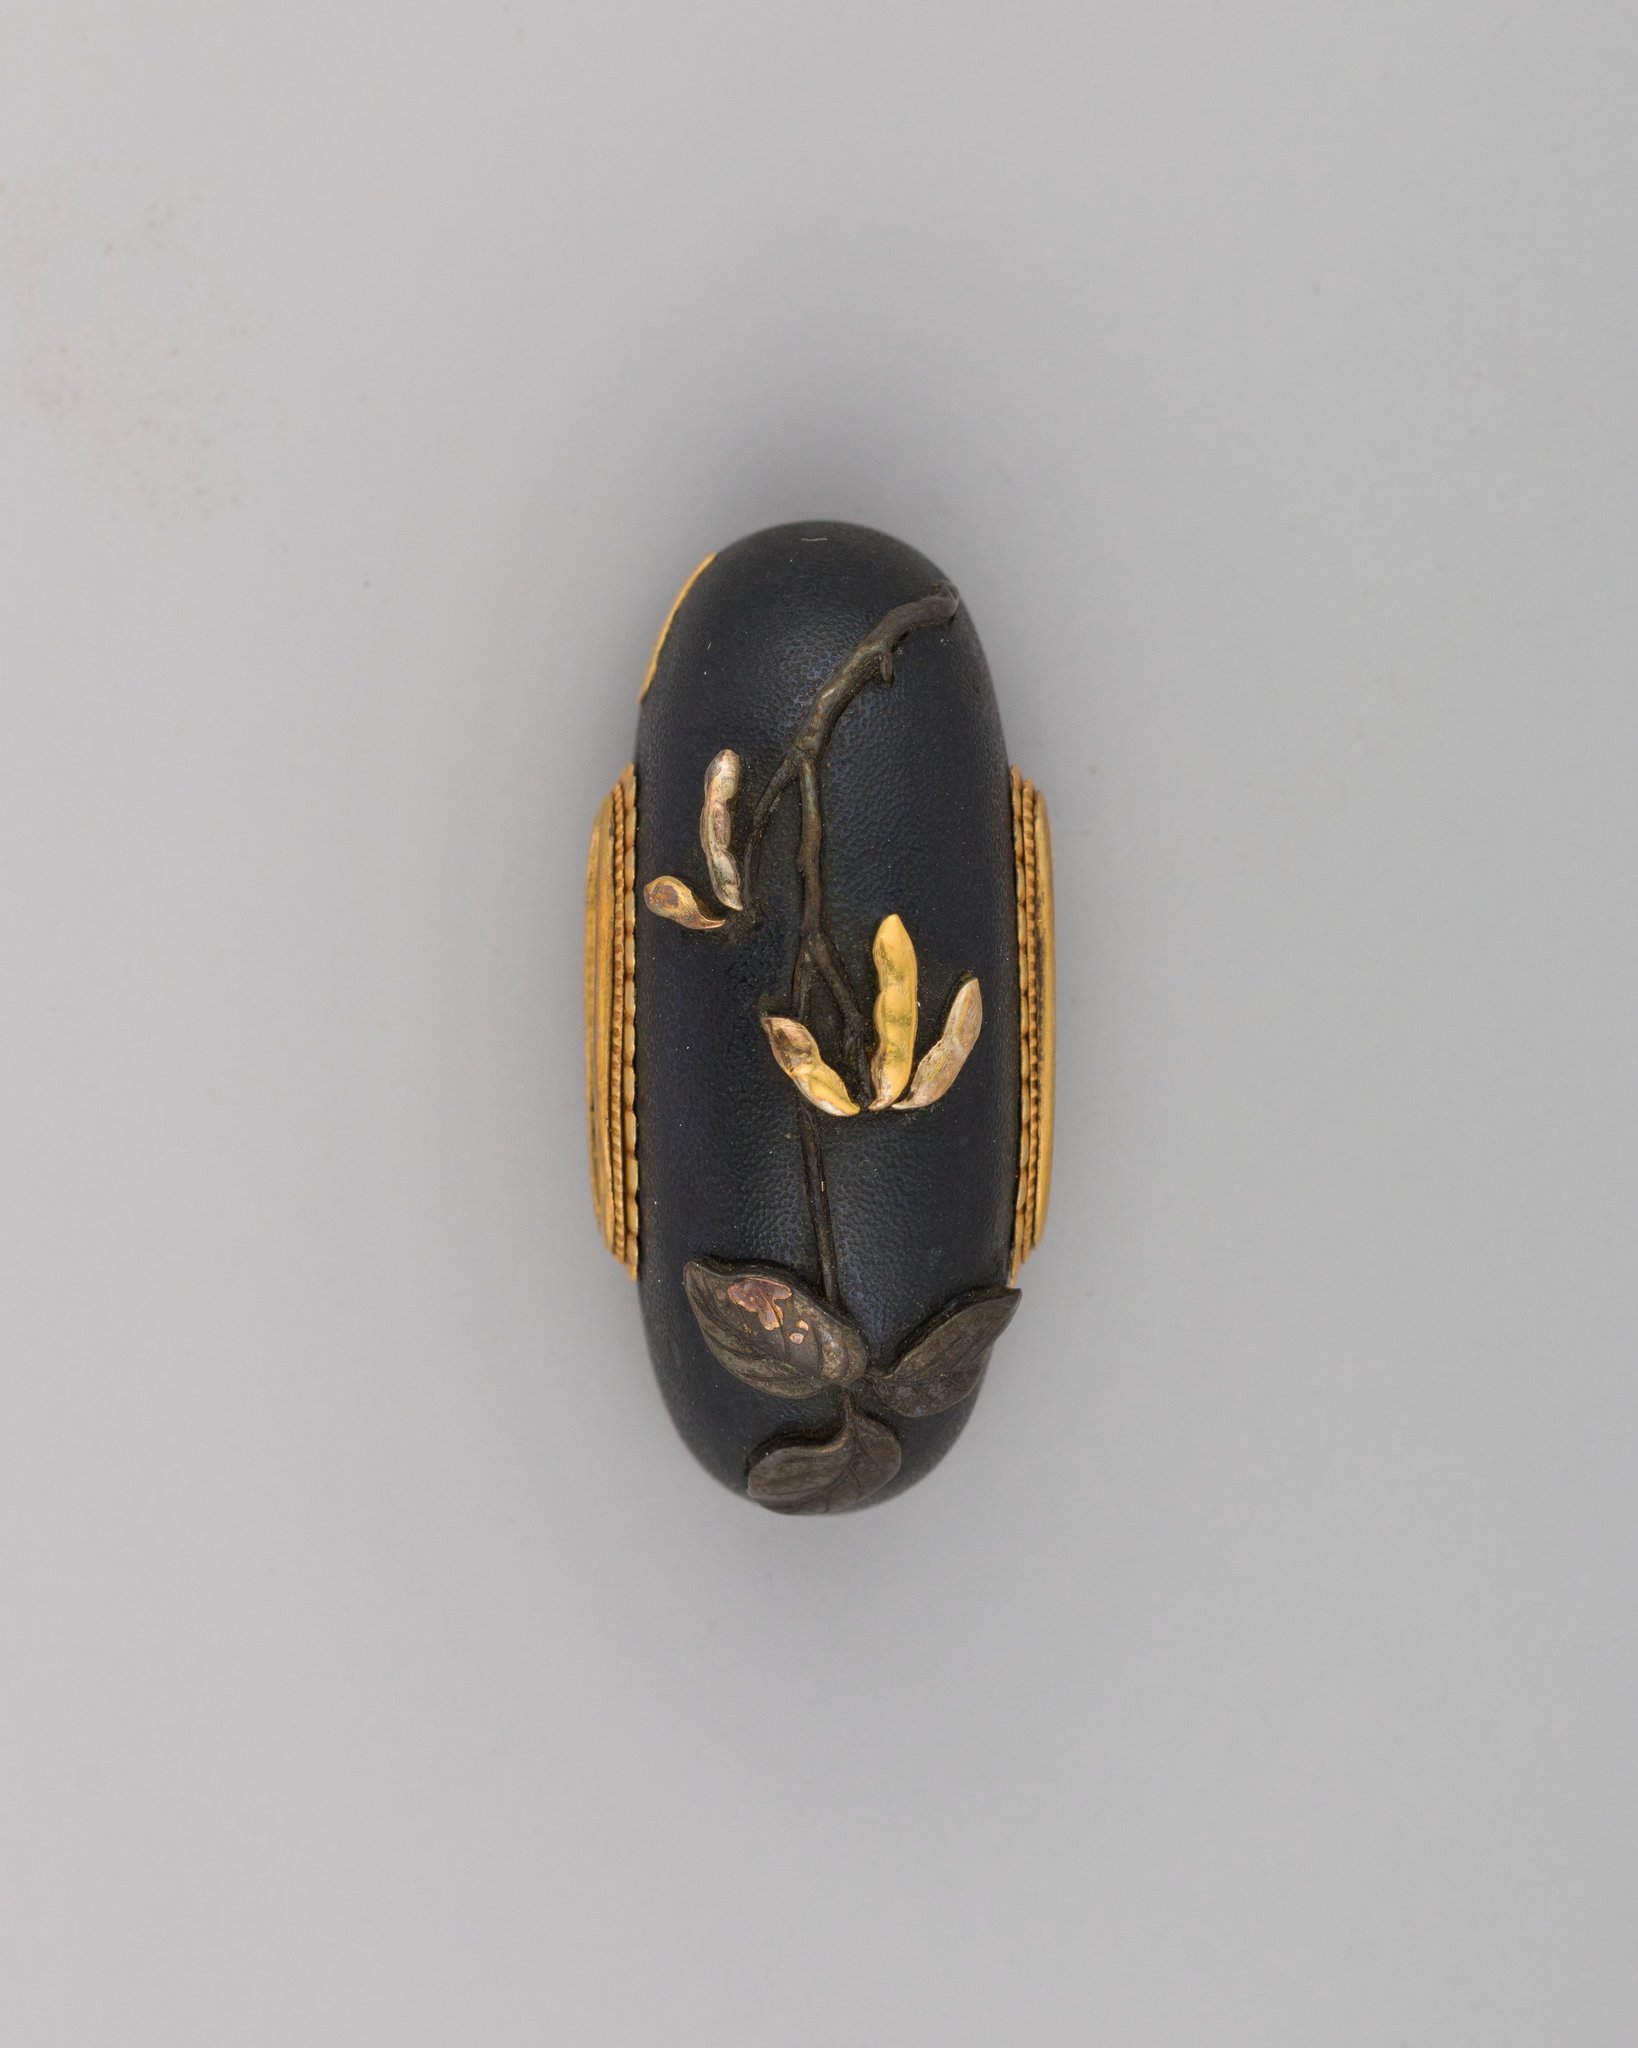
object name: cord knob kurigata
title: Cord Knob (Kurigata)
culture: japanese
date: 1801-1900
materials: gold alloy, silver alloy, gold, silver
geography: japan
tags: leaves